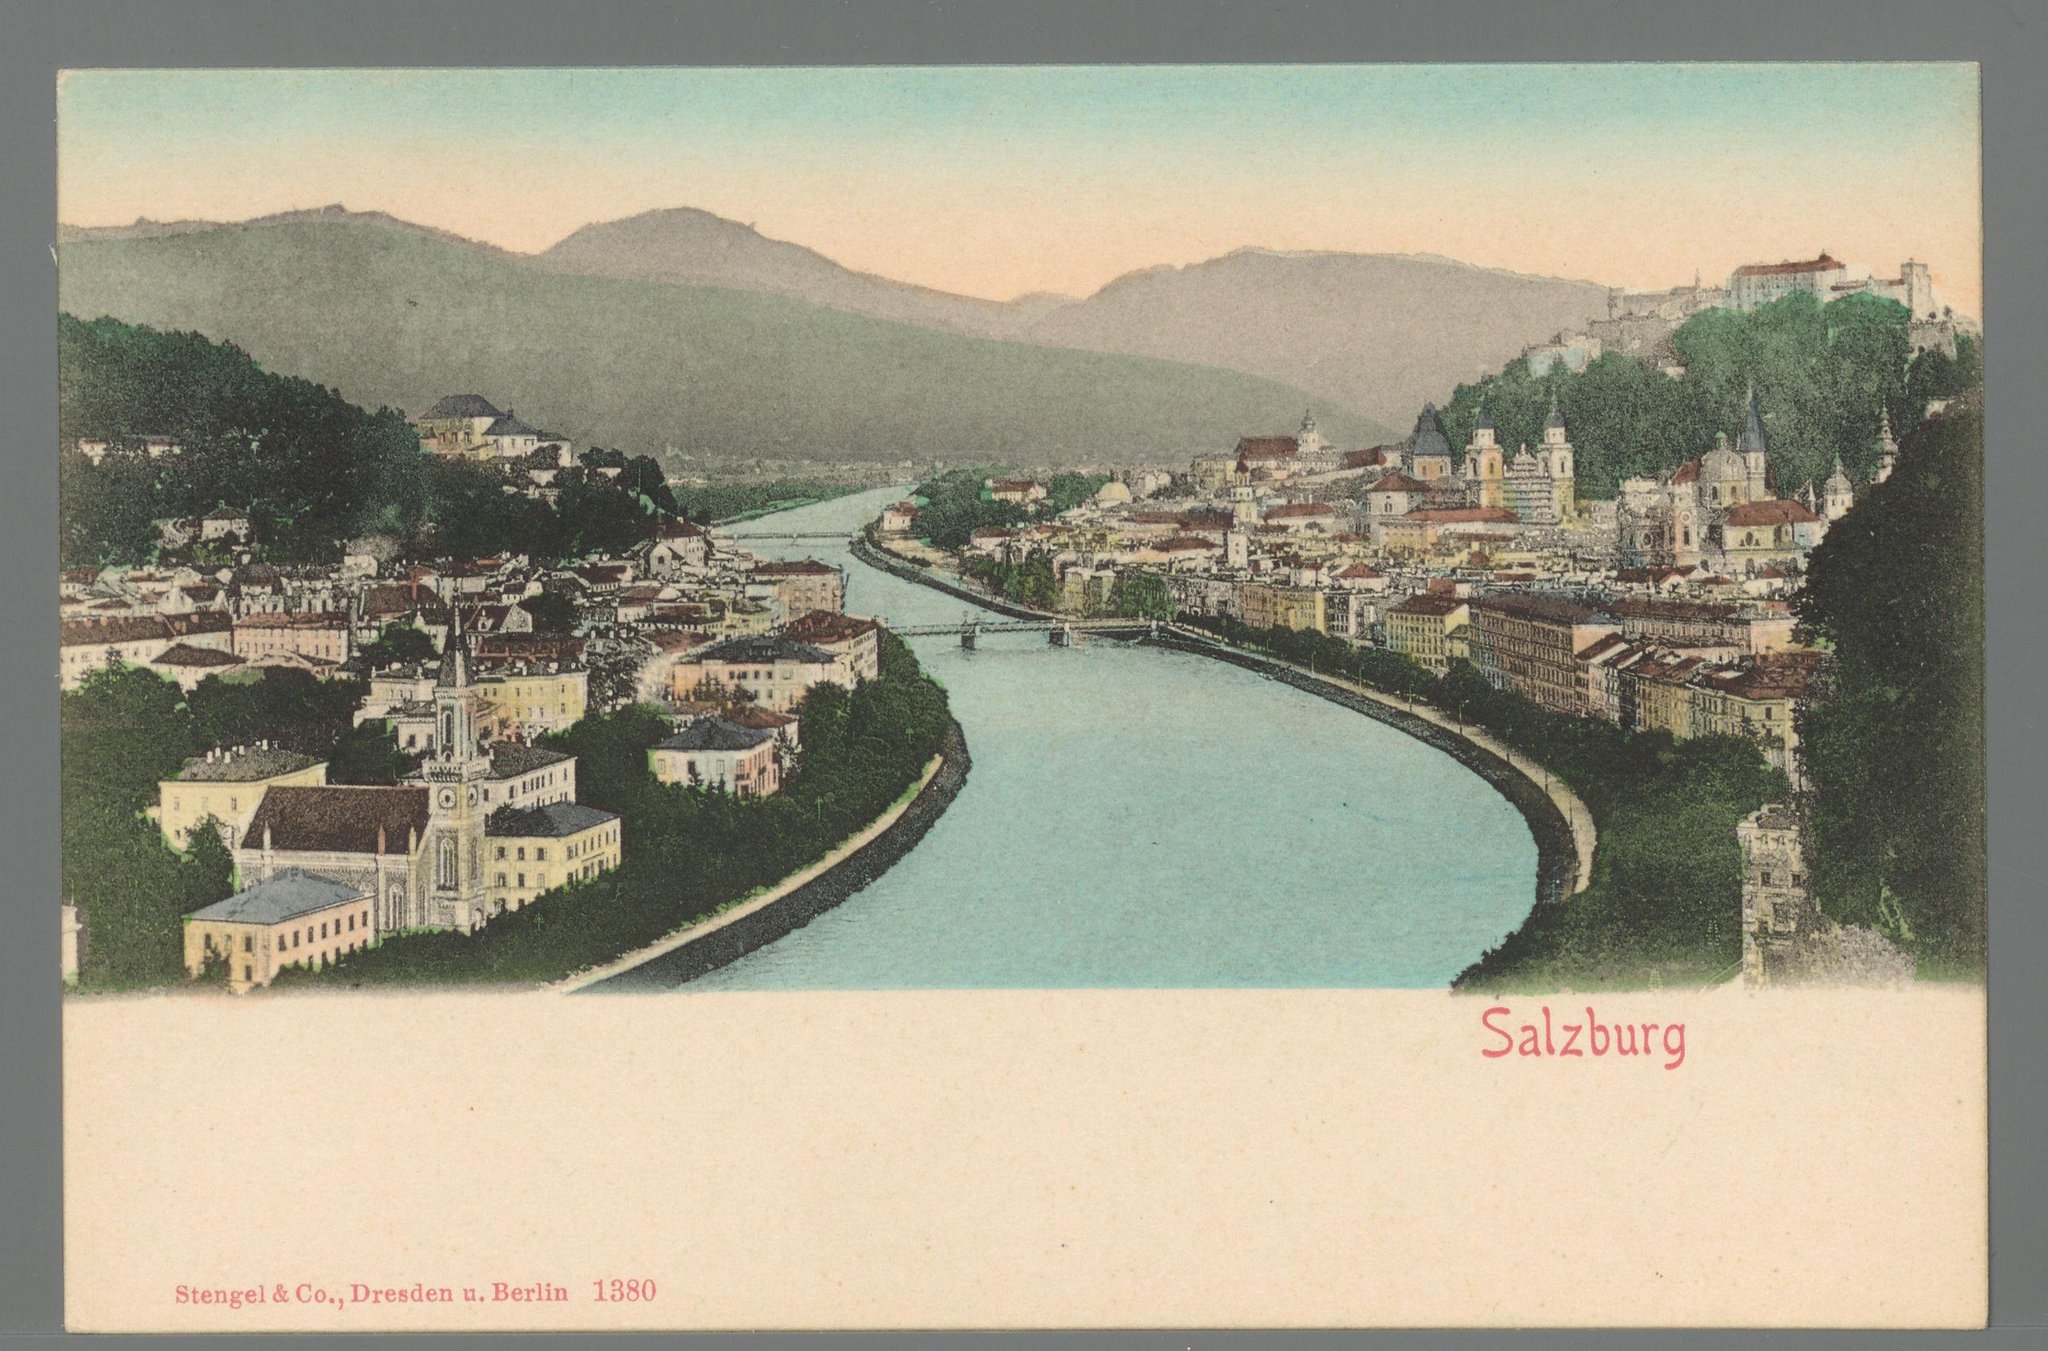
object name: photomechanical print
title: Salzburg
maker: Anonymous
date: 1890-1904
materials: cardboard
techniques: photograph, hand coloring, writing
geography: salzburg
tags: city-view, and landscape with man-made constructions, canals, waters (in city), mountains